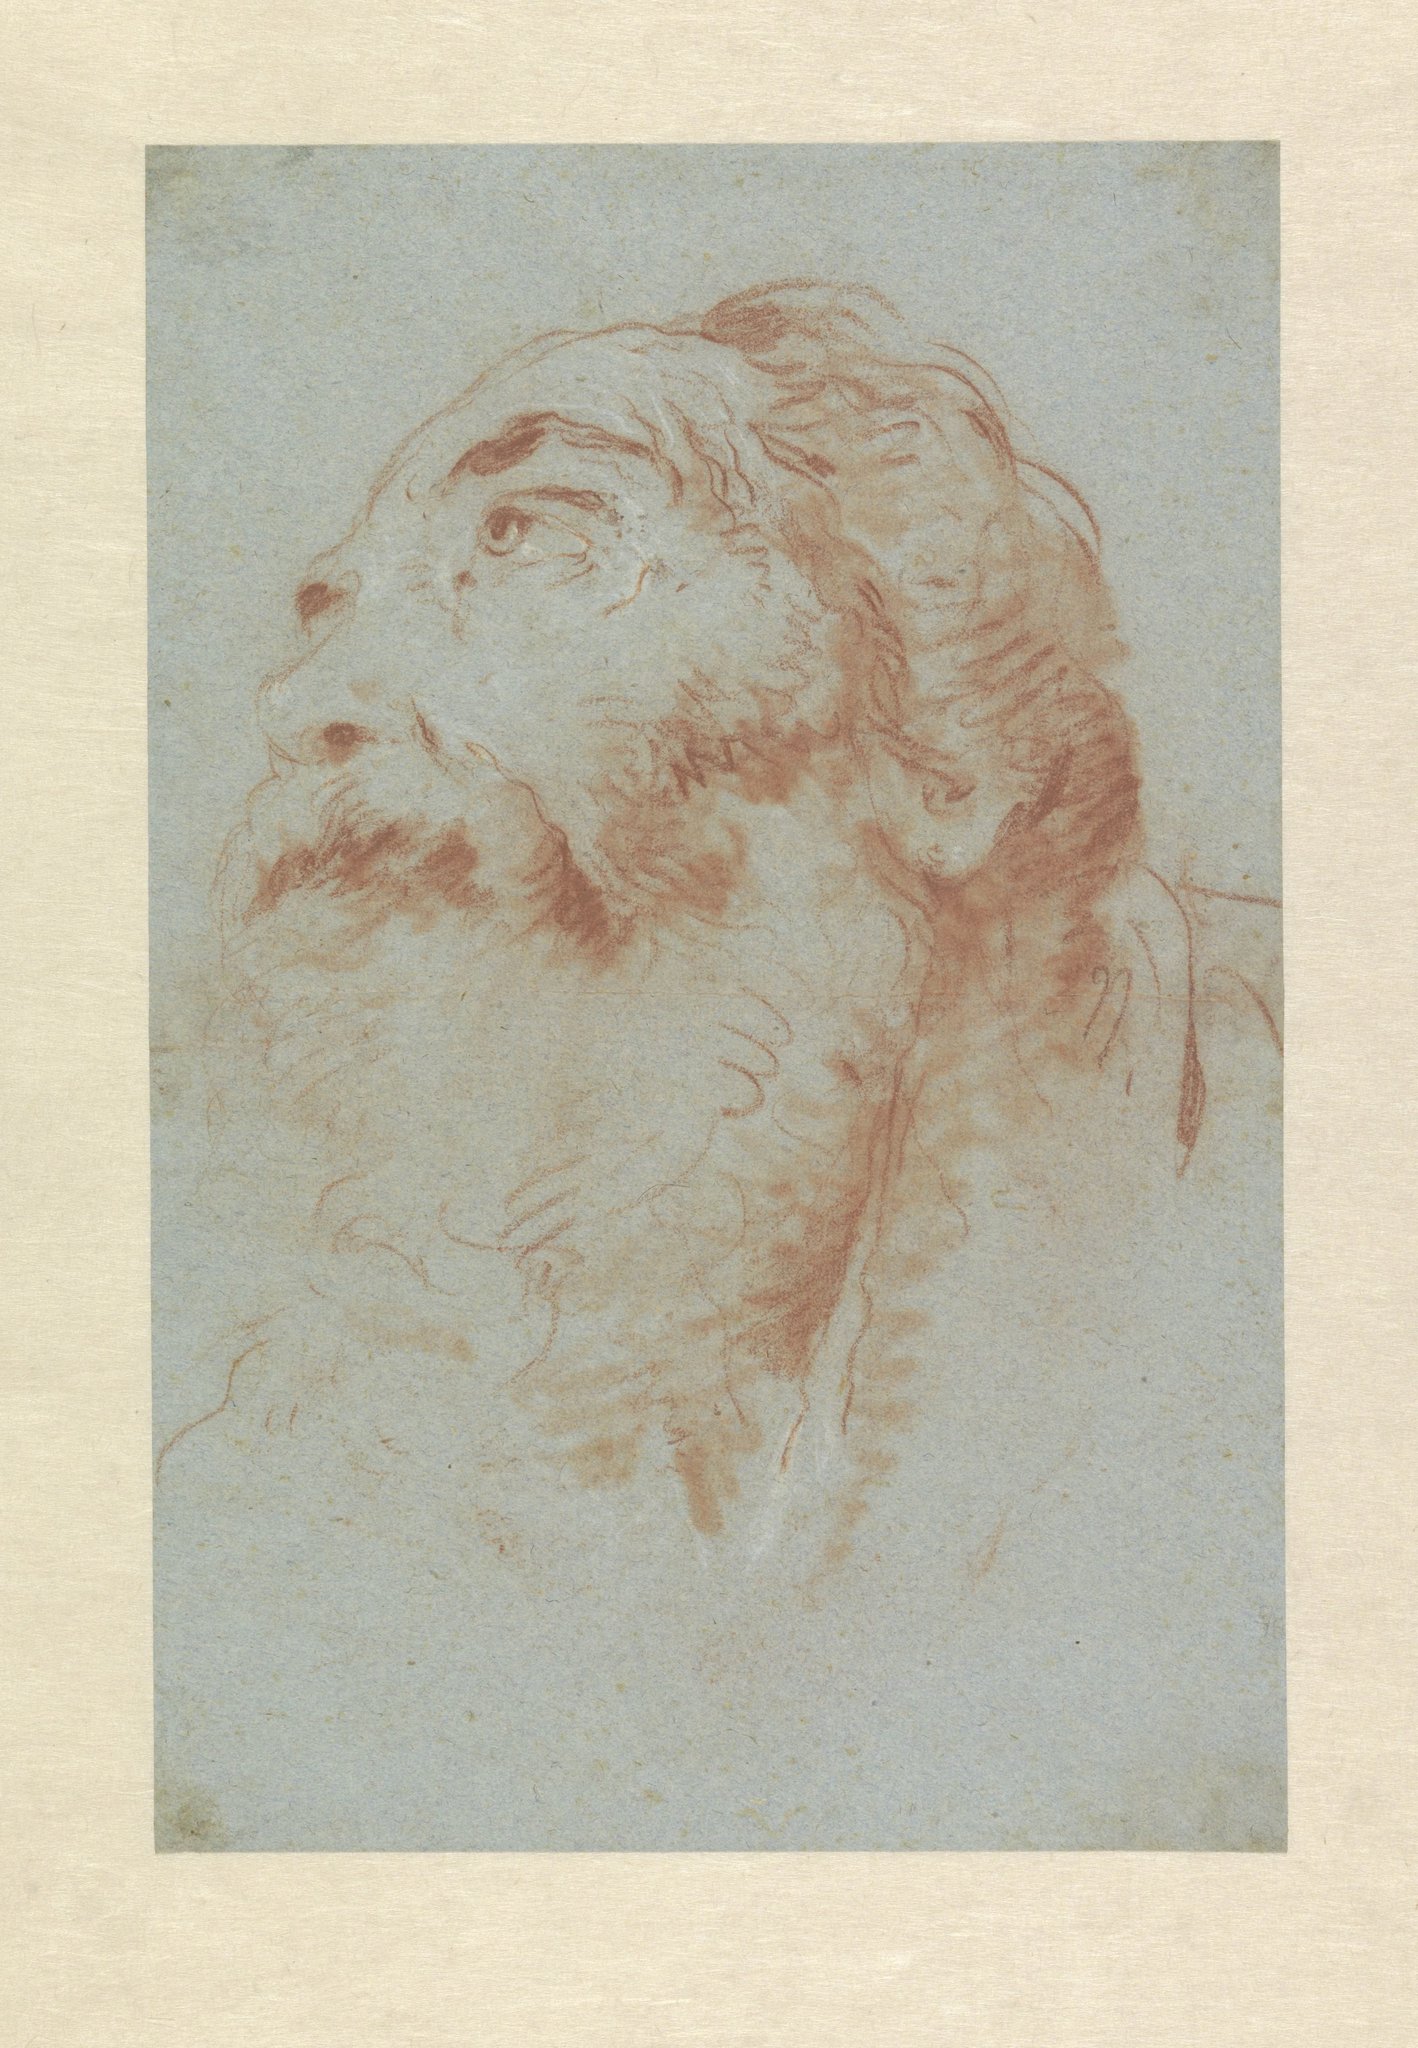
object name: drawing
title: Studie voor Joachim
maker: giovanni battista tiepolo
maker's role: draughtsman, painter, print maker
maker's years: 1696-1770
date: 1754-1759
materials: chalk, paper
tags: head (human), old man, the father of mary, joachim; possible attributes: book, two doves, lamb, (shepherd's) staff, story of joachim and anna